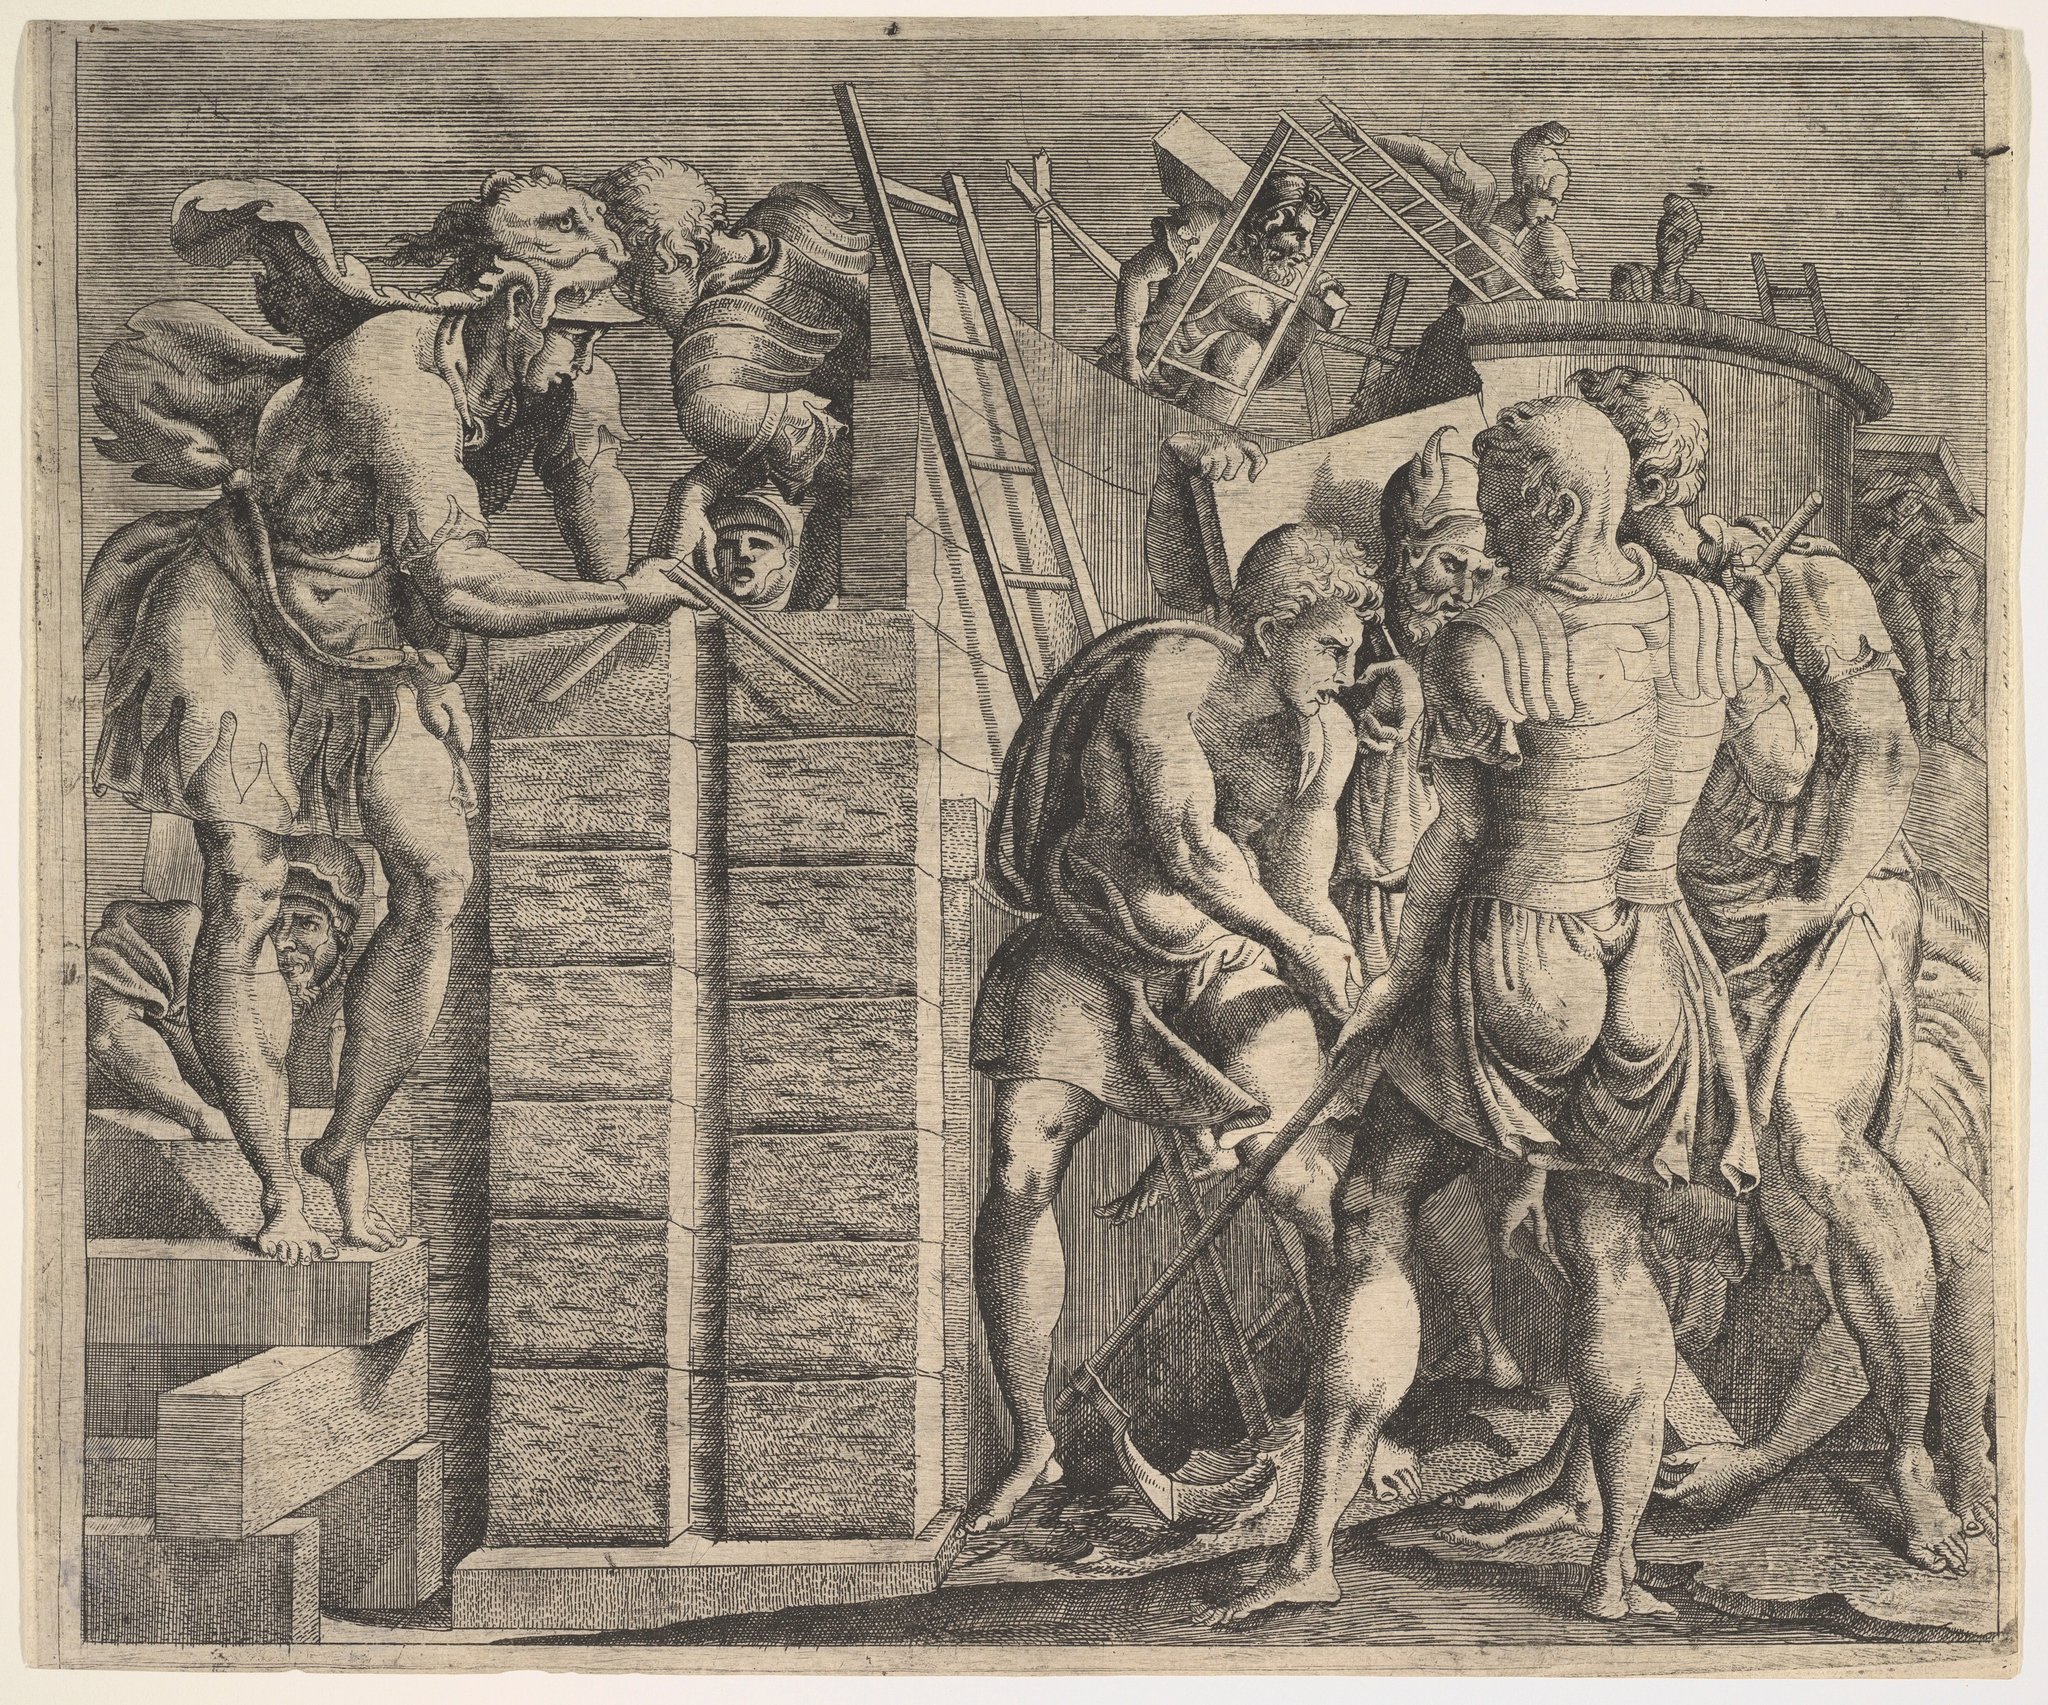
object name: print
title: Cadmus Founding Thebes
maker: master of the story of cadmus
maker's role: artist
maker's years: 1540-1547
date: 1543-1544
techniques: etching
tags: soldiers,kings,men,working,ladders